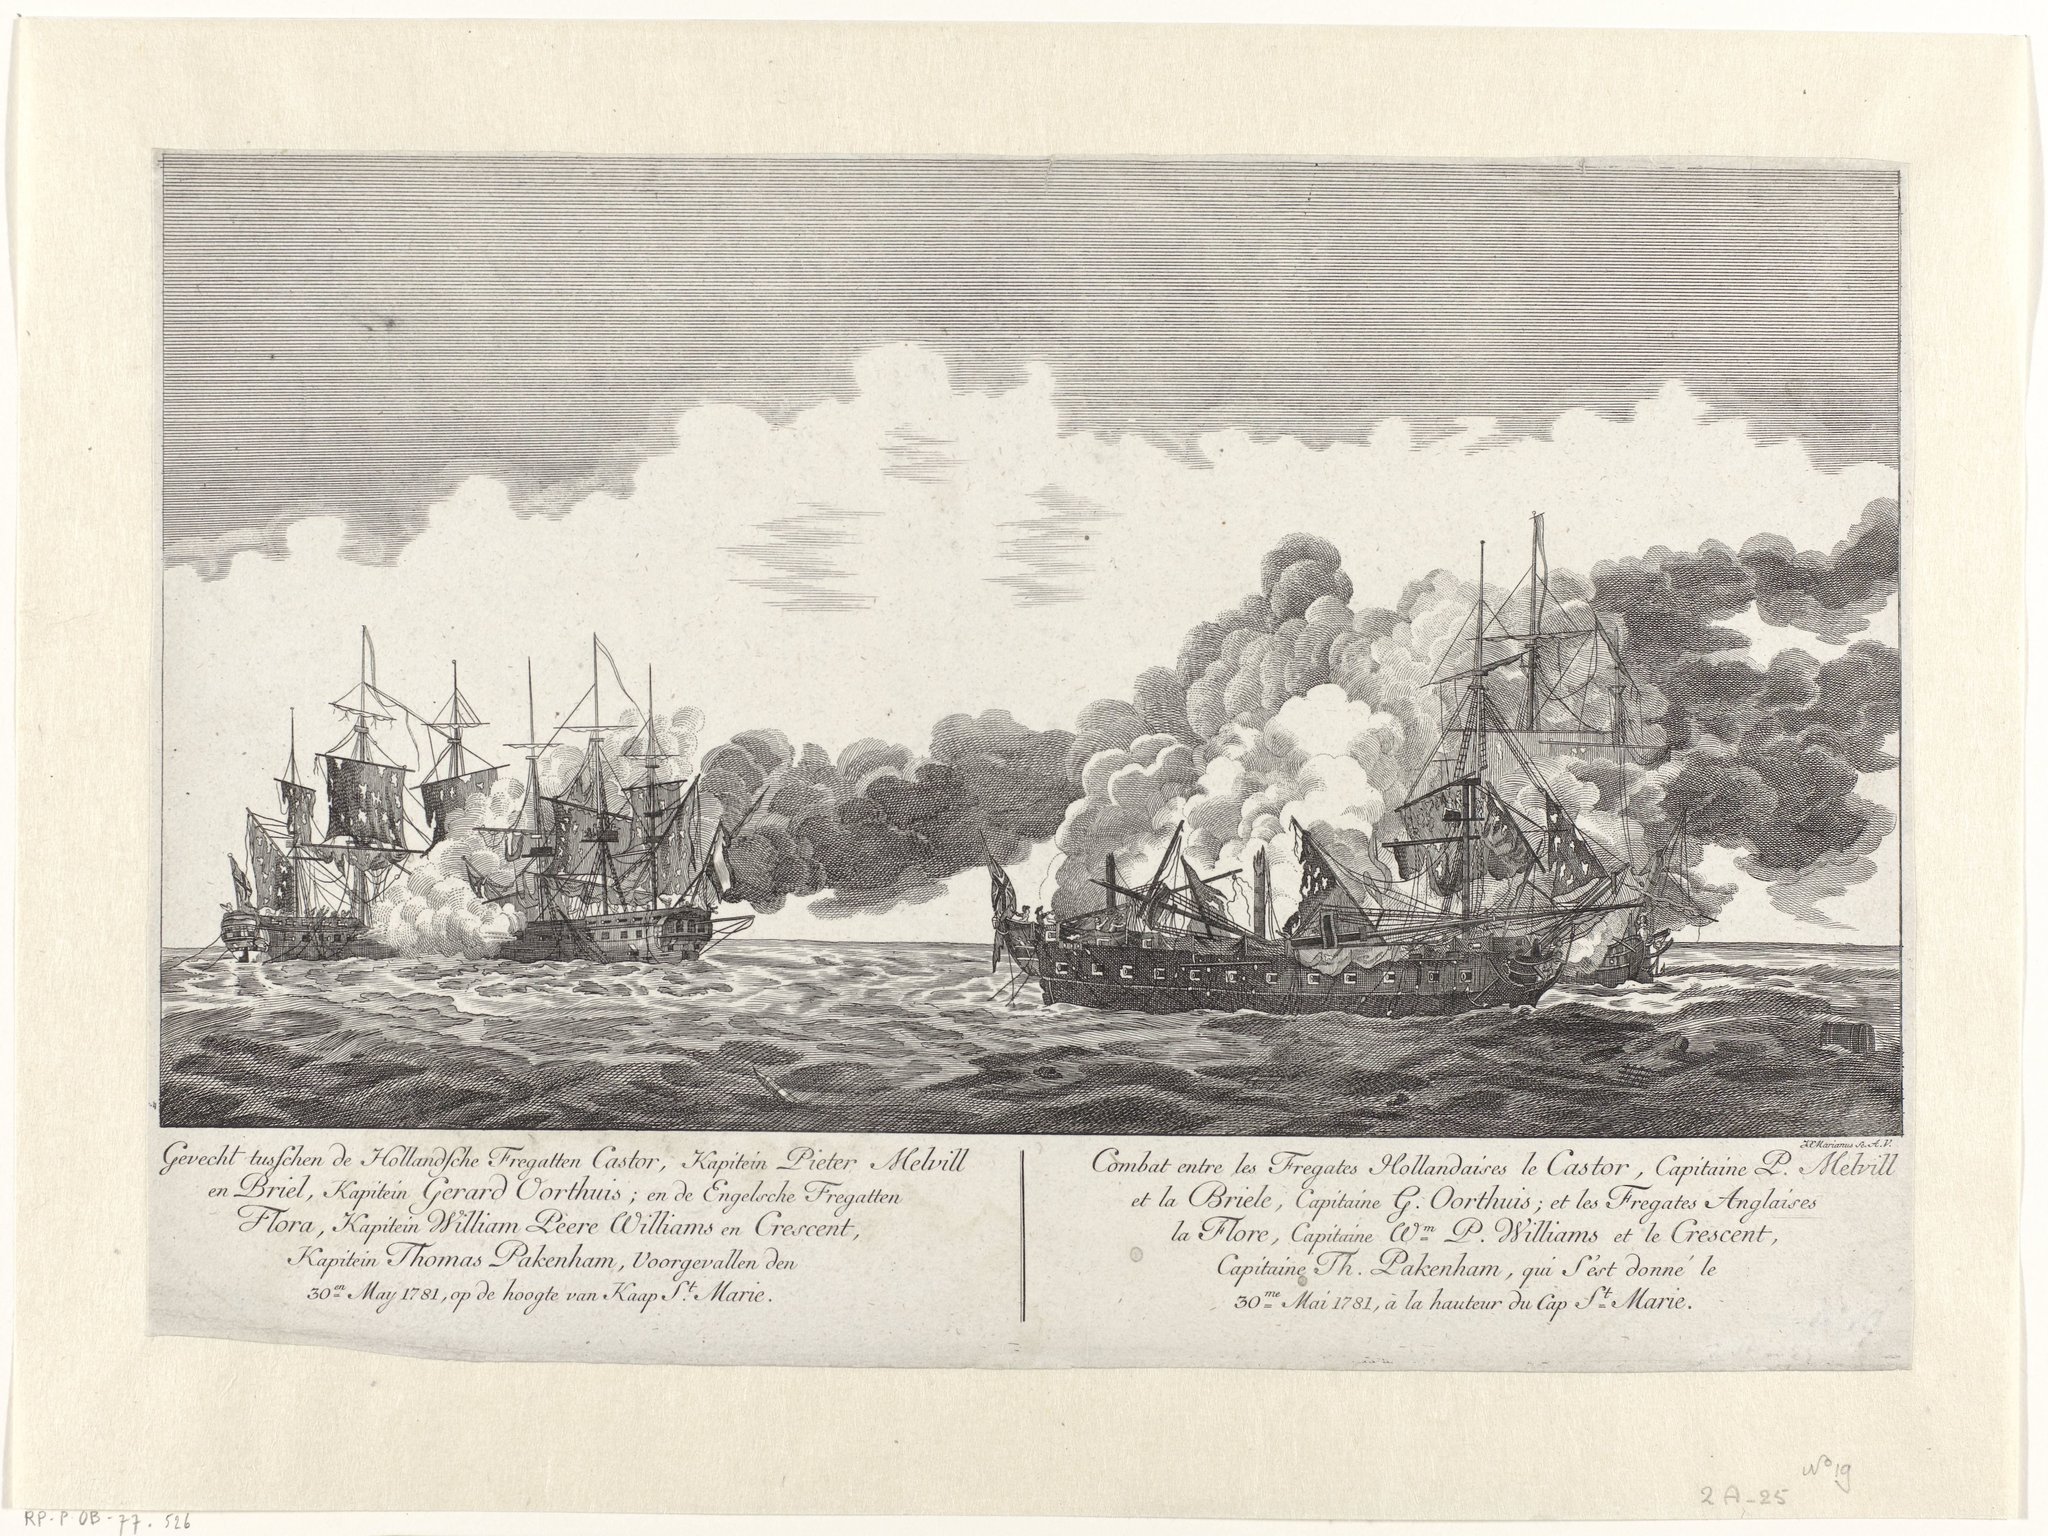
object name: print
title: Vier prenten van zeeslagen uit 1781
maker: joseph marianus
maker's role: print maker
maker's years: 1738-1788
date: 1781-1788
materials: paper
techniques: engraving, etching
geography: augsburg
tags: dordrecht, the hague, naval officer, pieter melvill van carnbee, rotterdam, gerardus oorthuys, battle (+ naval force)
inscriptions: collector's mark: Lugt 2228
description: Kopie naar de prent van Mathias de Sallieth uit 1781 (FMH 4405a). Onderdeel van een serie van vier platen van zeeslagen in 1781, Duitse kopieën door J. Marianaus, waarvan verder alleen FMH 4430 in de collectie aanwezig is. Muller vermeldt bij FMH 4430 (Supplement) twee andere platen, destijds in de collectie Nijland.